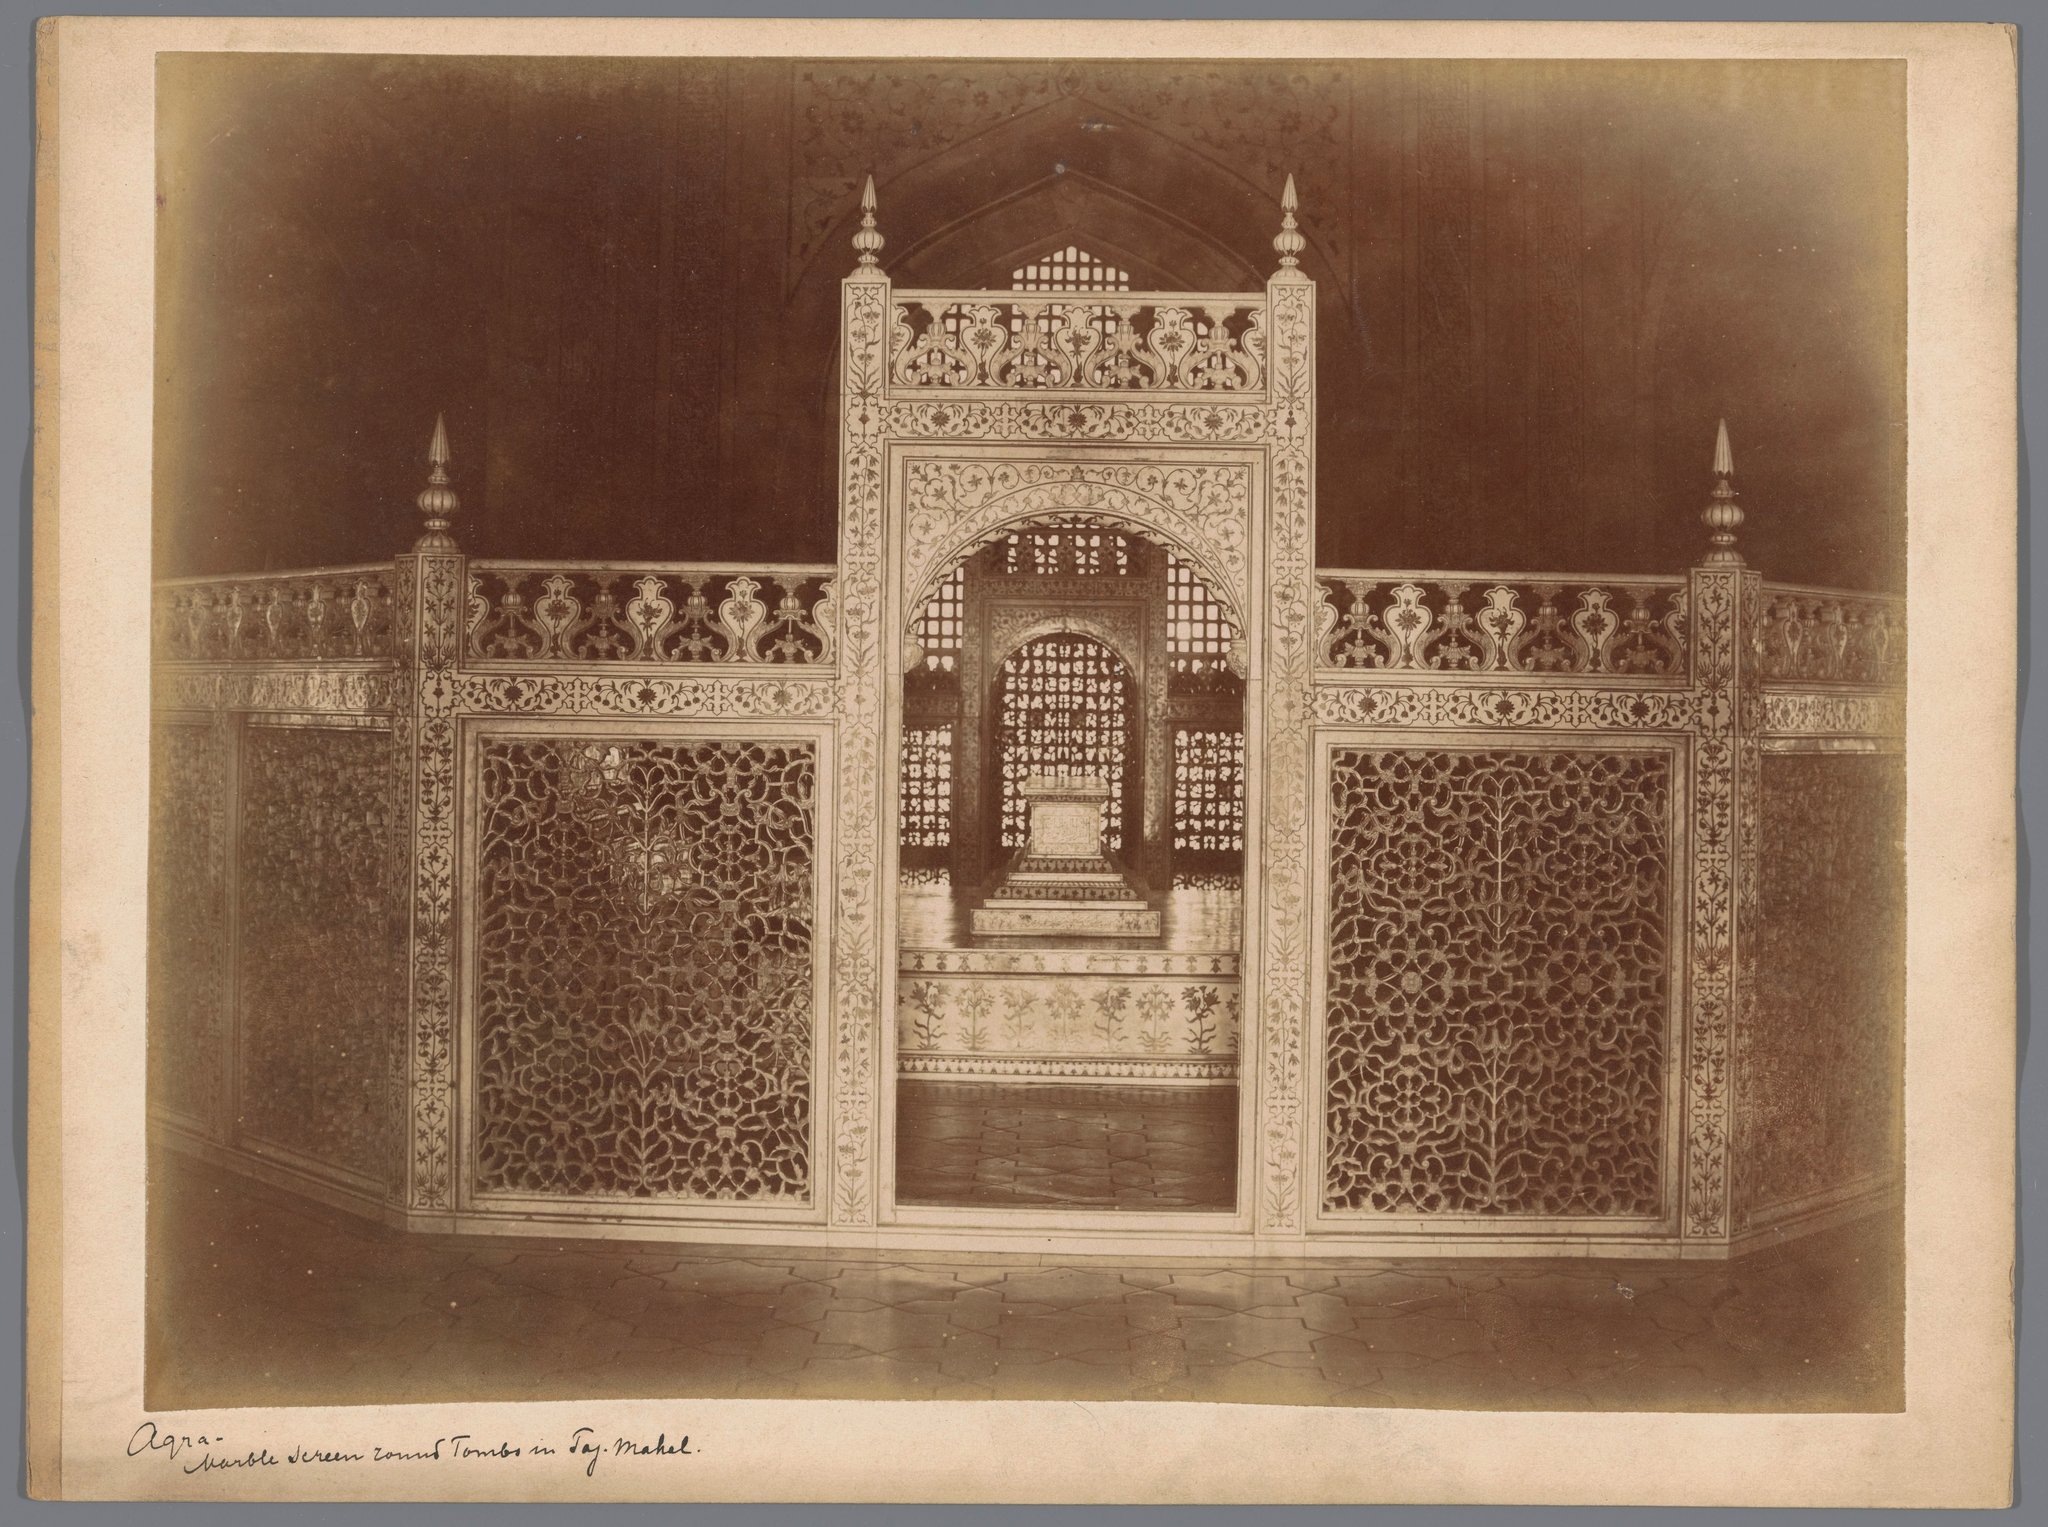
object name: photograph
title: Marble screens at the sarcophagi in the Taj Mahal, Agra, Uttar Pradesh, India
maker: Anonymous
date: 1865-1890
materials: cardboard, paper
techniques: albumen print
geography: taj mahal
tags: carving ~ applied arts, fence, wall, paling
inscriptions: title: ‘Agra -/ Marble screen round Tombs in Taj Mahal.’, number: ‘15’